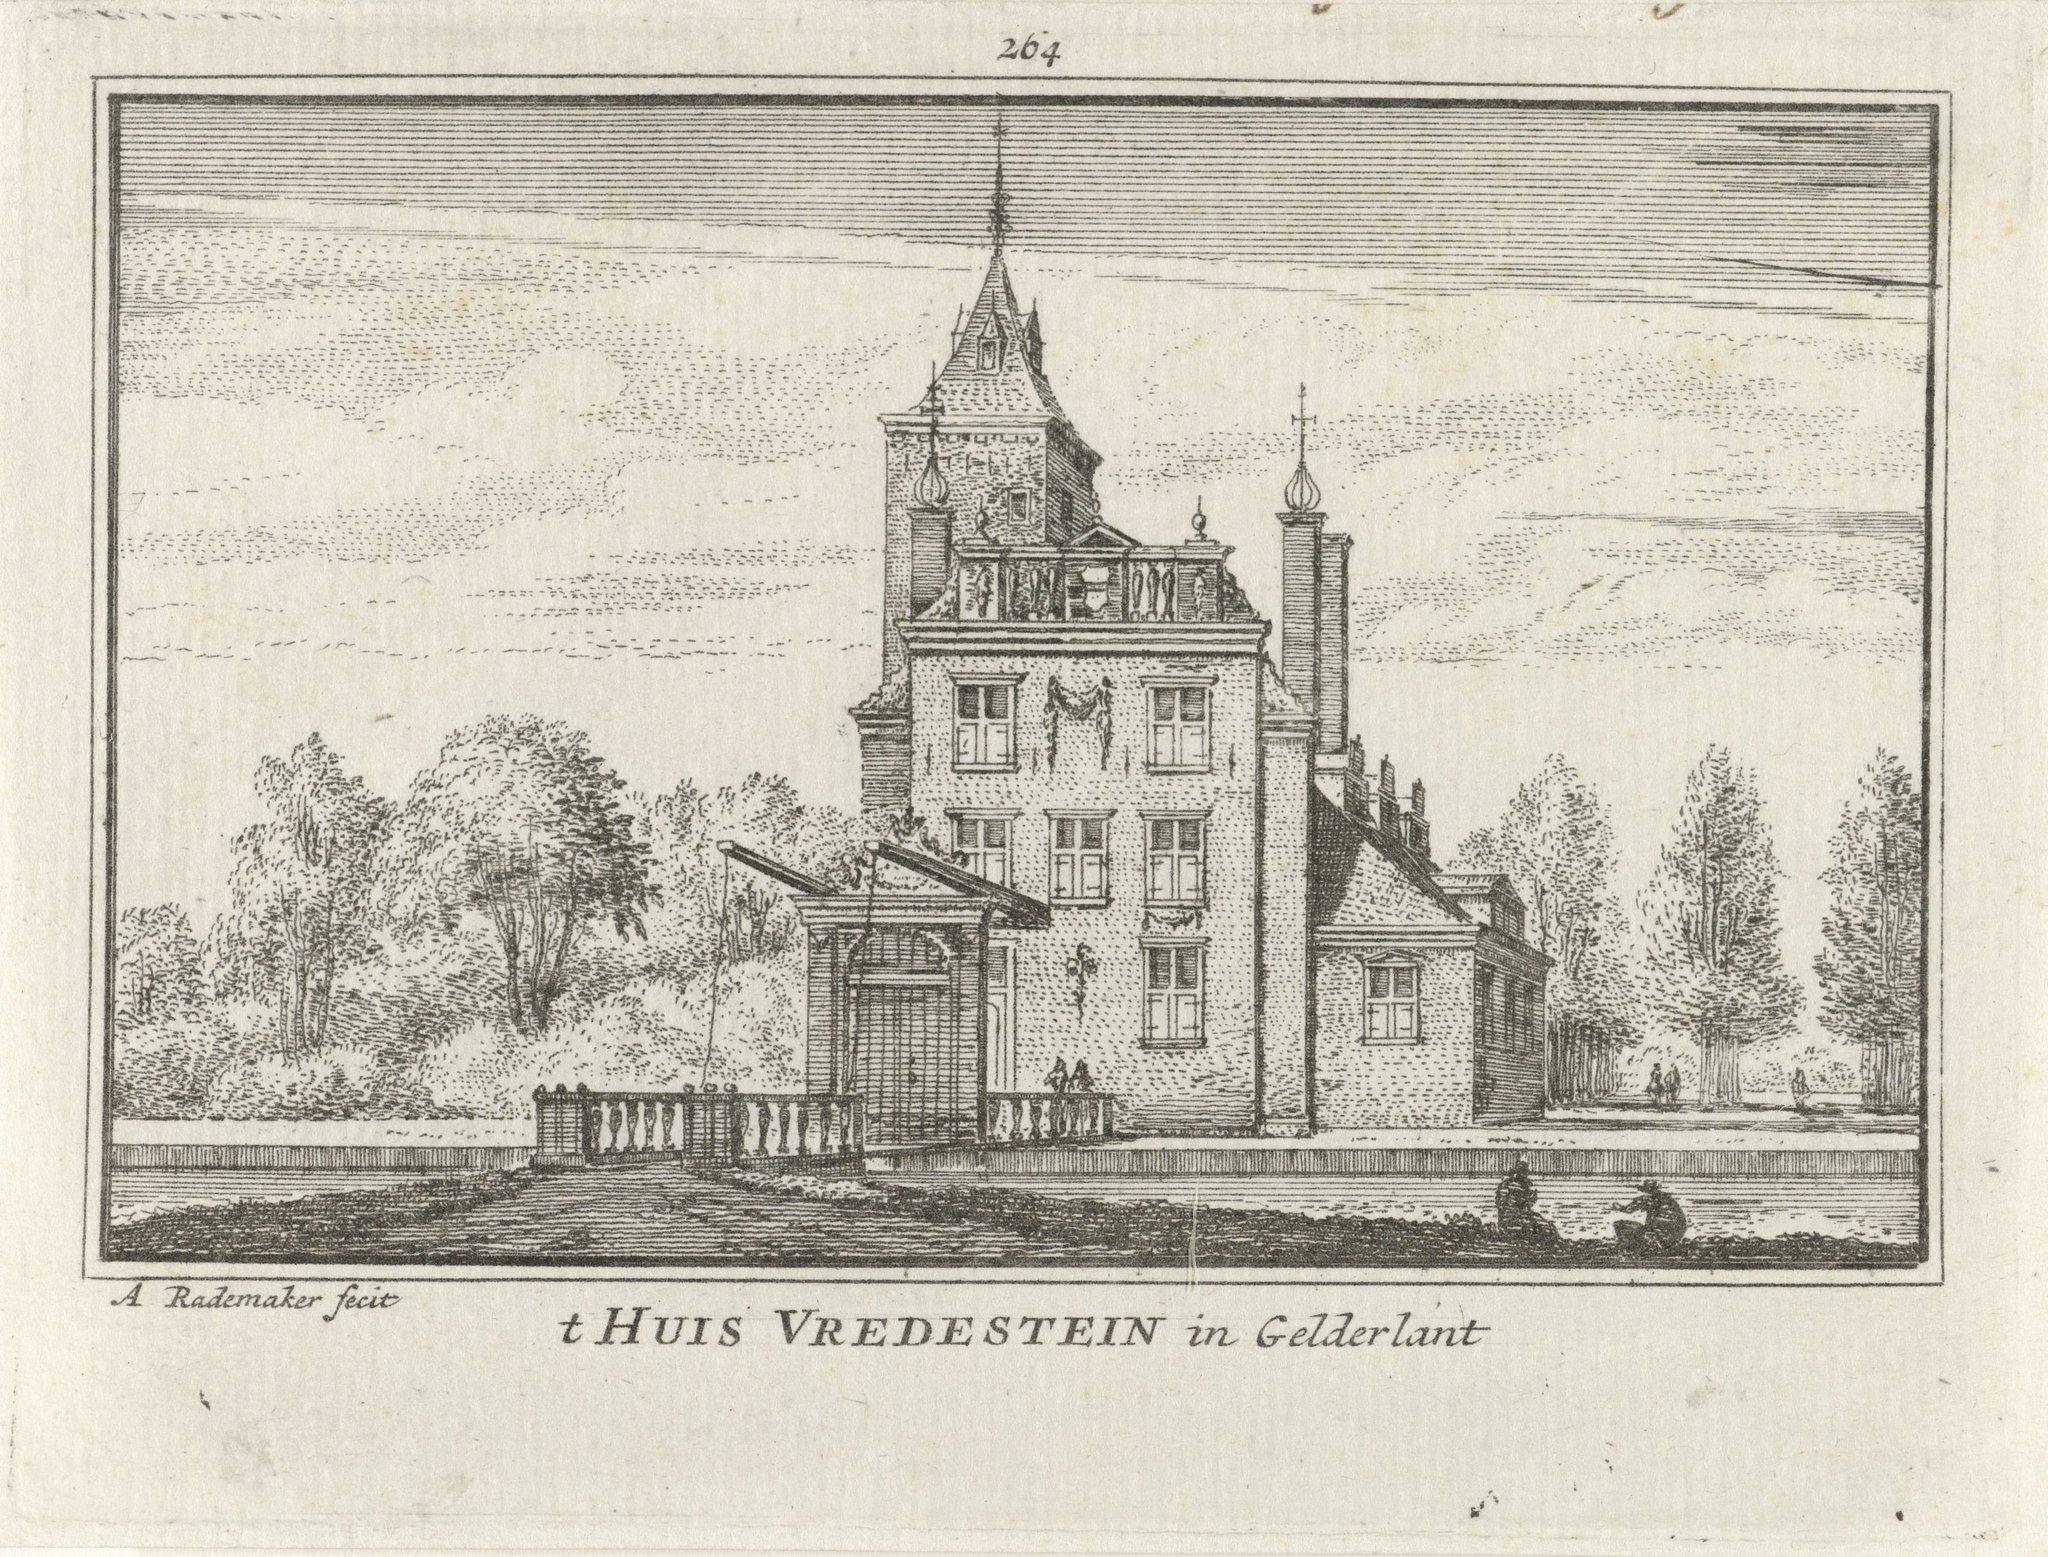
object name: print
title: Huis Vredestein bij Ravenswaaij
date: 1727-1733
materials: paper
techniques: etching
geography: amsterdam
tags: castle, rural housing, e.g. country-house, villa, cottage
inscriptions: collector's mark: Lugt 2228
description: Illustratie uit: Abraham Rademaker, Matthaeus Brouërius van Niedek, Isaac Le Long, Kabinet van Nederlandsche en Kleefsche outheden en (...) voorname stads- en landgebouwen, Willem Barents en Antoni Schoonenburg: Amsterdam, 1727-1733, ill. nr. 264.